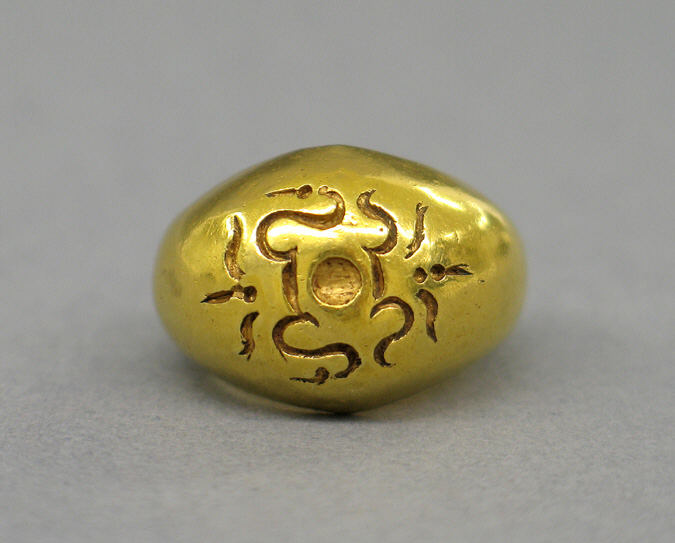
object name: ring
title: Solid Cast Ring with Sri Inscription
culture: indonesian, javanese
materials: gold